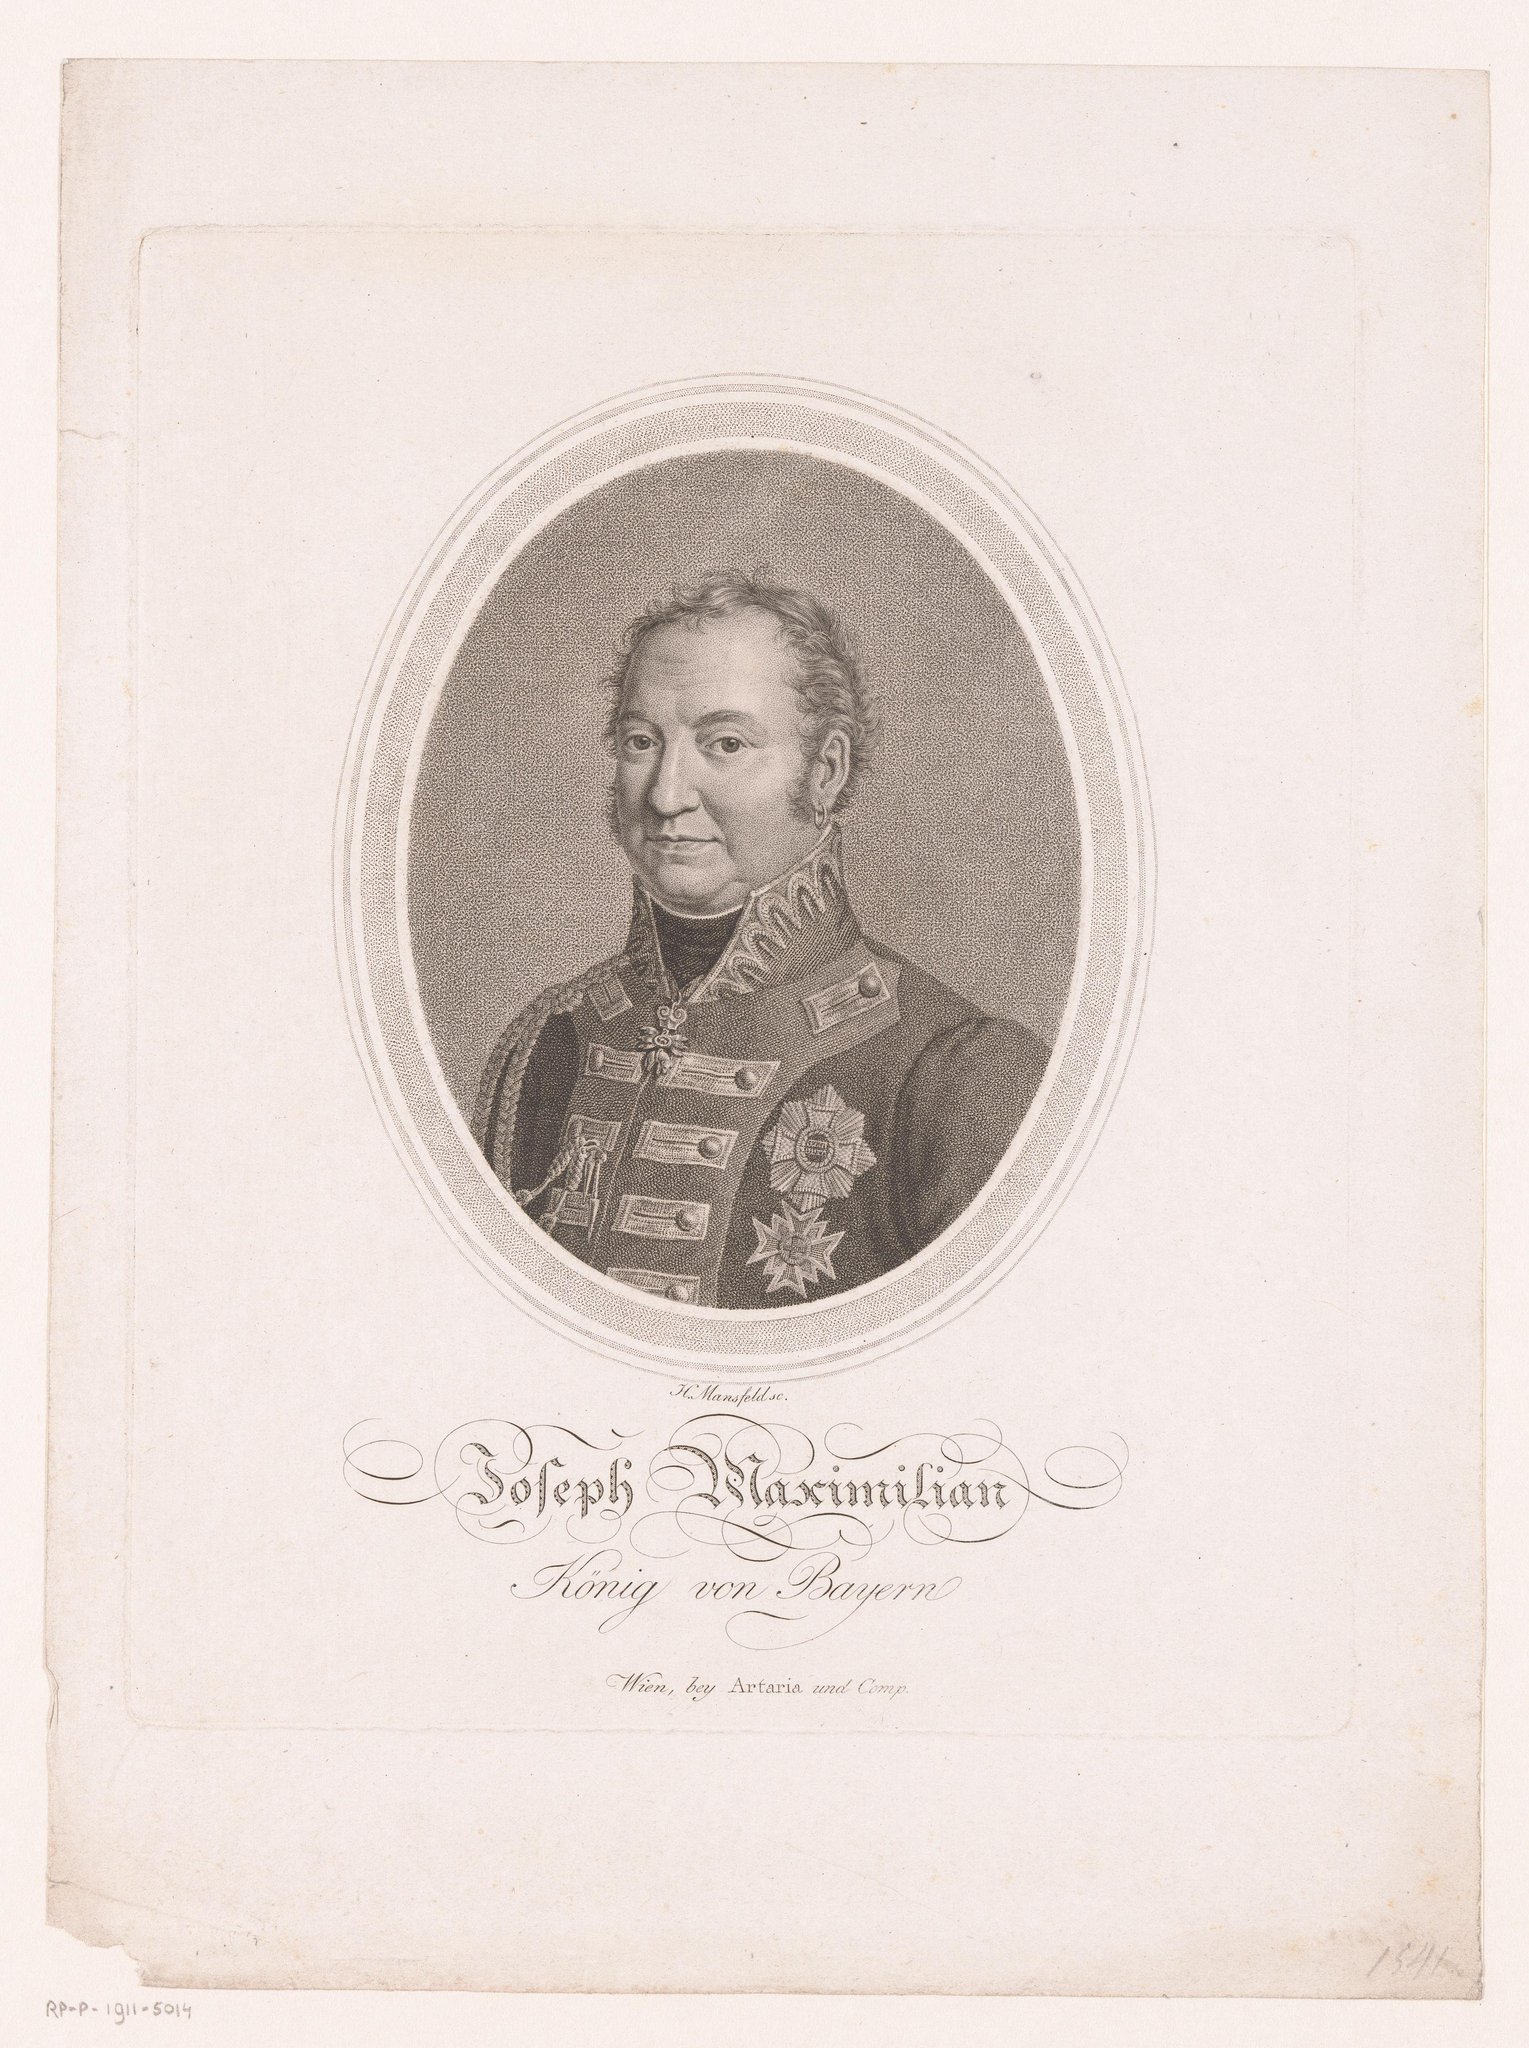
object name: print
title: Portret van Maximiliaan I Jozef van Beieren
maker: heinrich joseph mansfeld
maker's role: print maker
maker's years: 1785-1866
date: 1795-1866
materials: paper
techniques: stippling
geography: vienna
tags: maximiliaan i (keurvorst van beieren), historical persons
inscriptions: inscription: ‘No 1843’, collector's mark: Lugt 2228